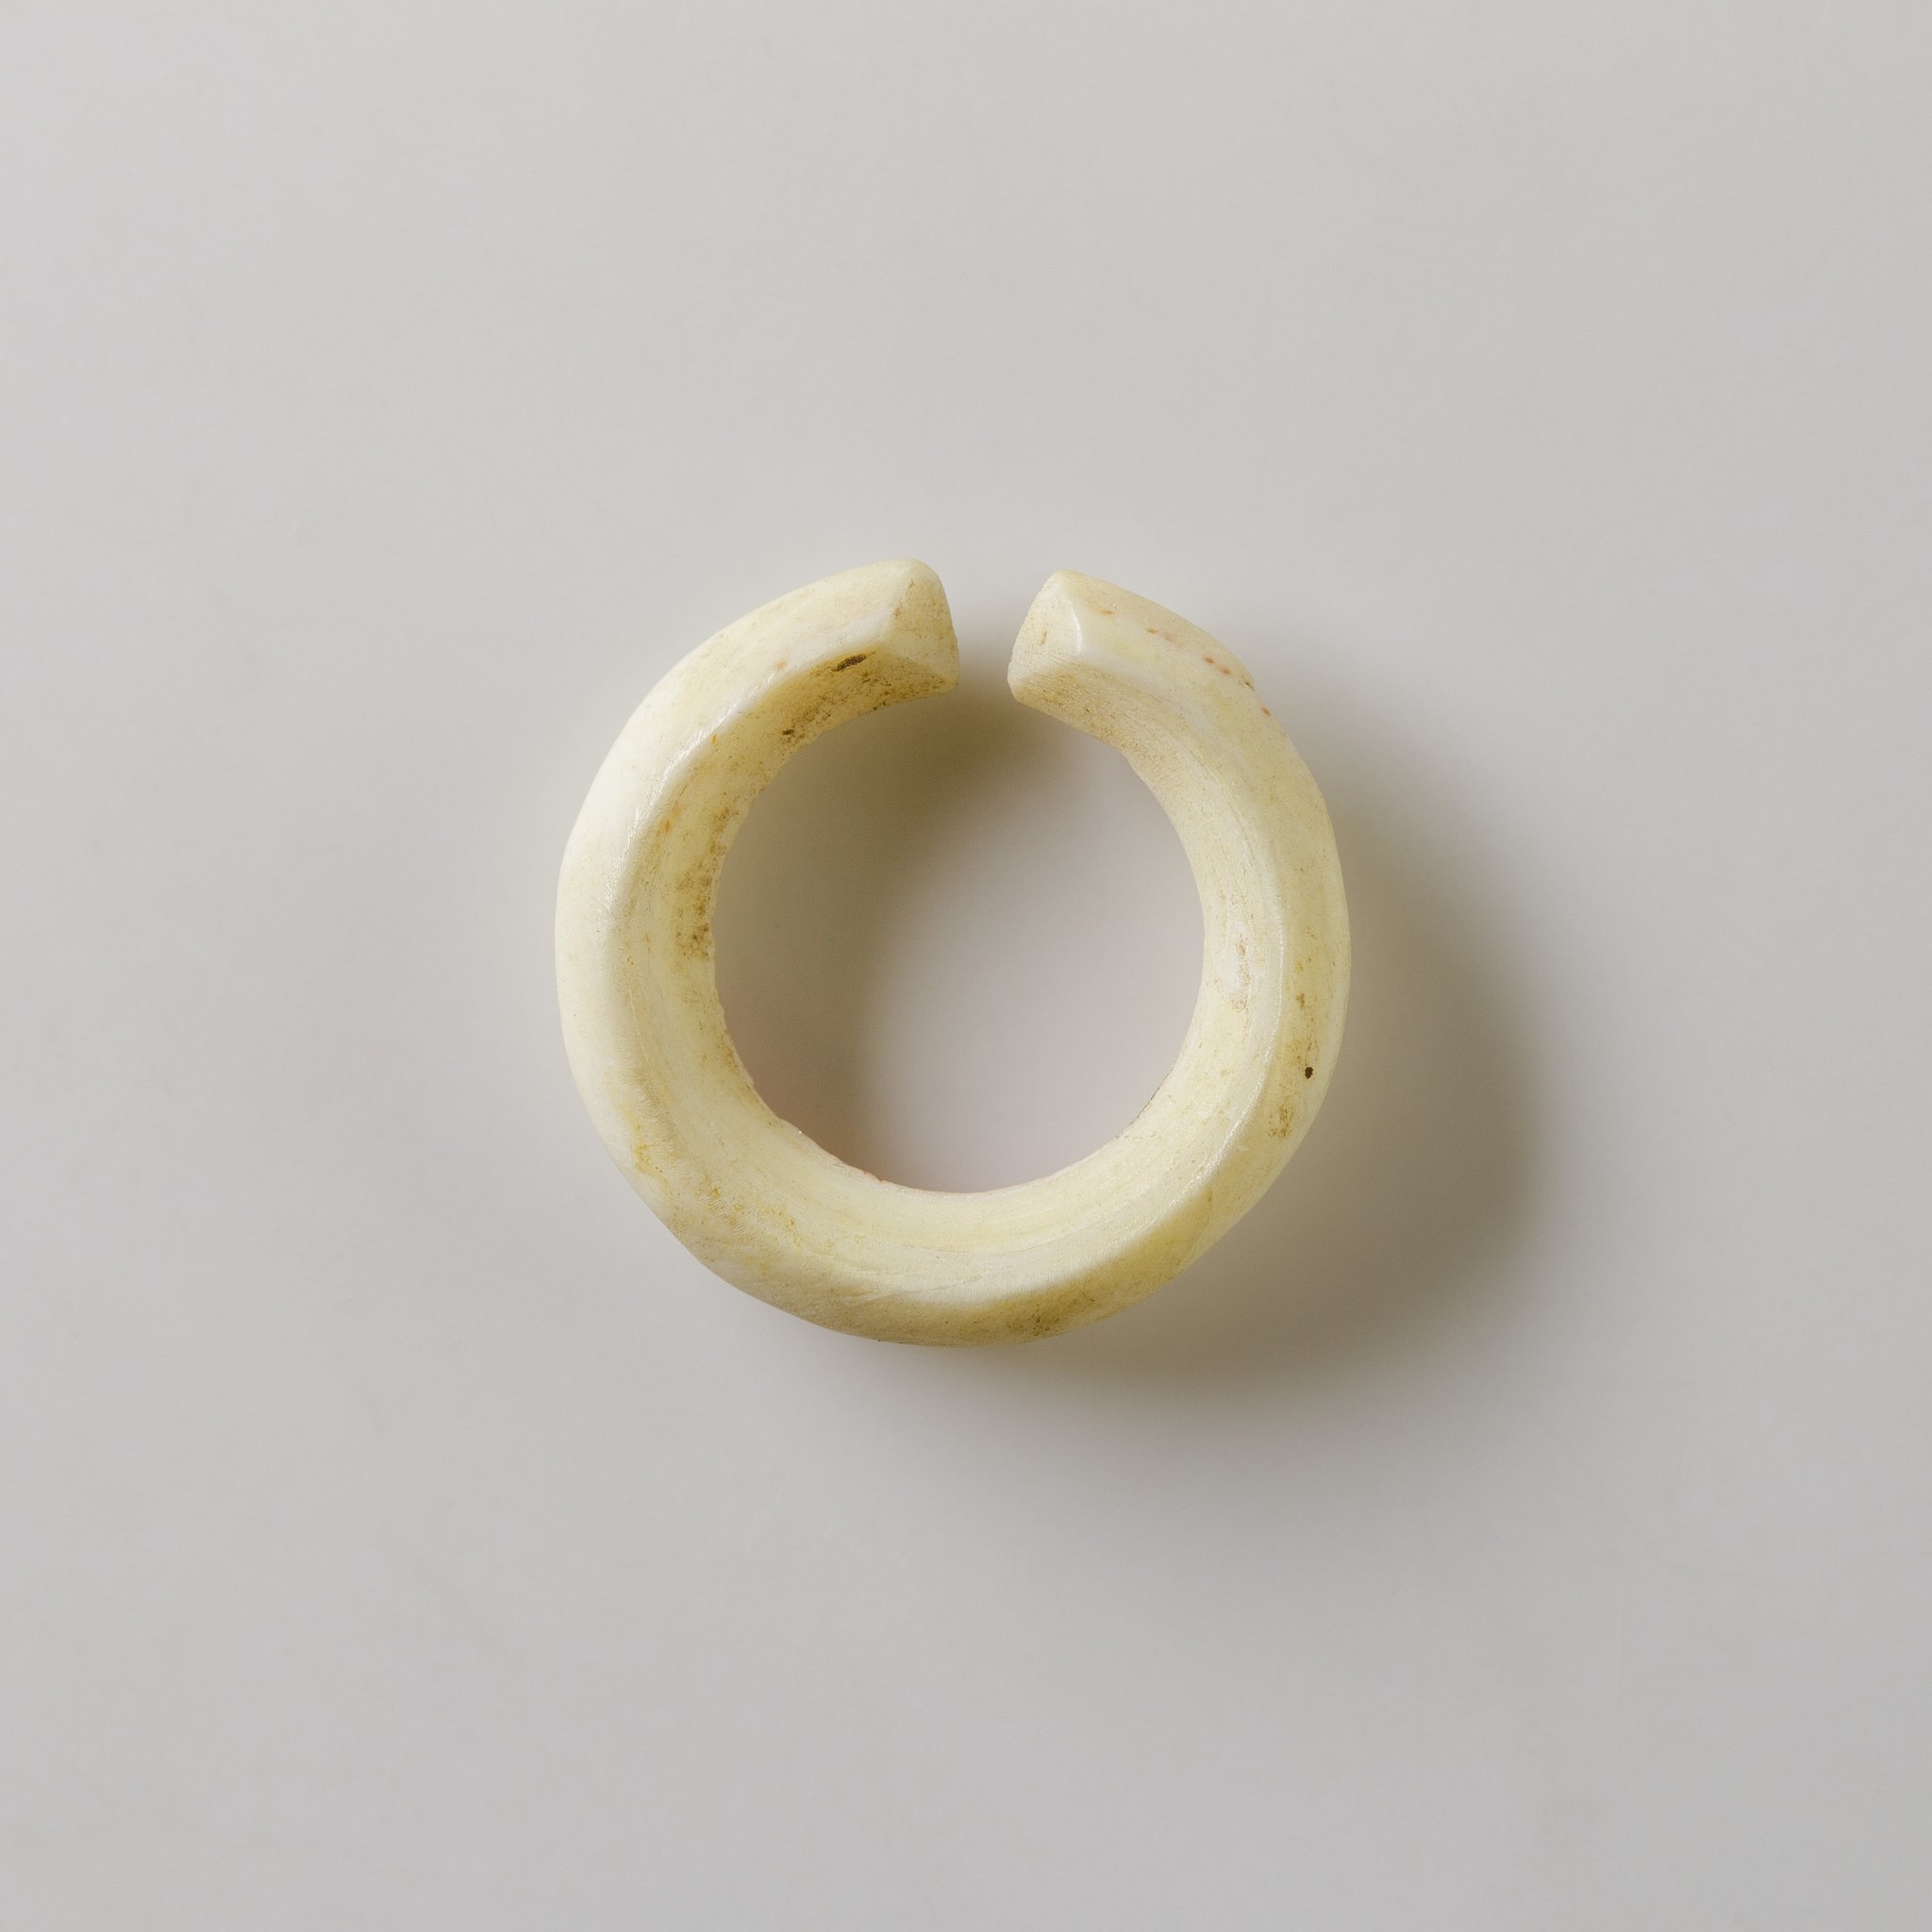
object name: hair ring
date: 1070-343 BCE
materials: shell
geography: egypt